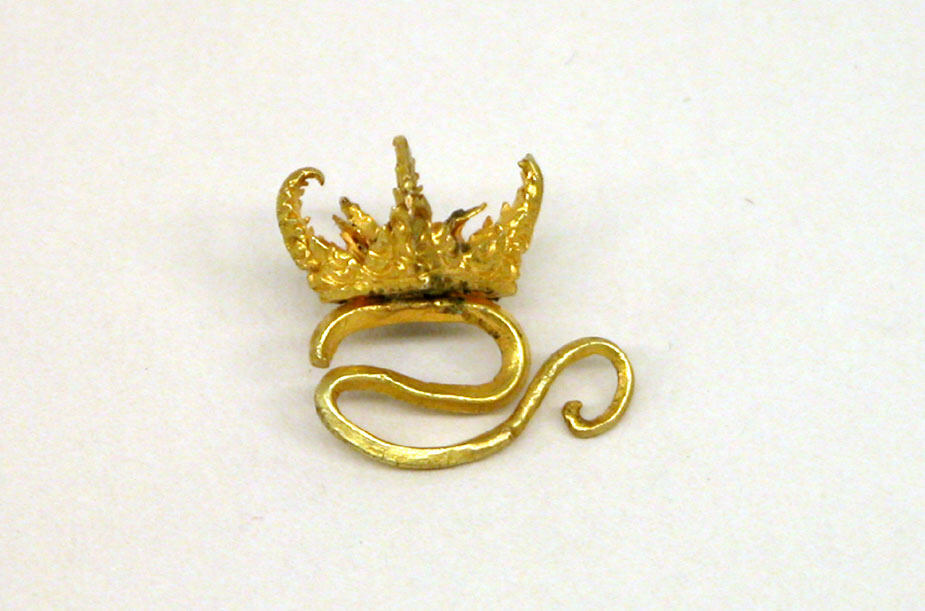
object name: ear ornament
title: Pair of Ear Ornament Settings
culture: indonesian, javanese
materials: gold